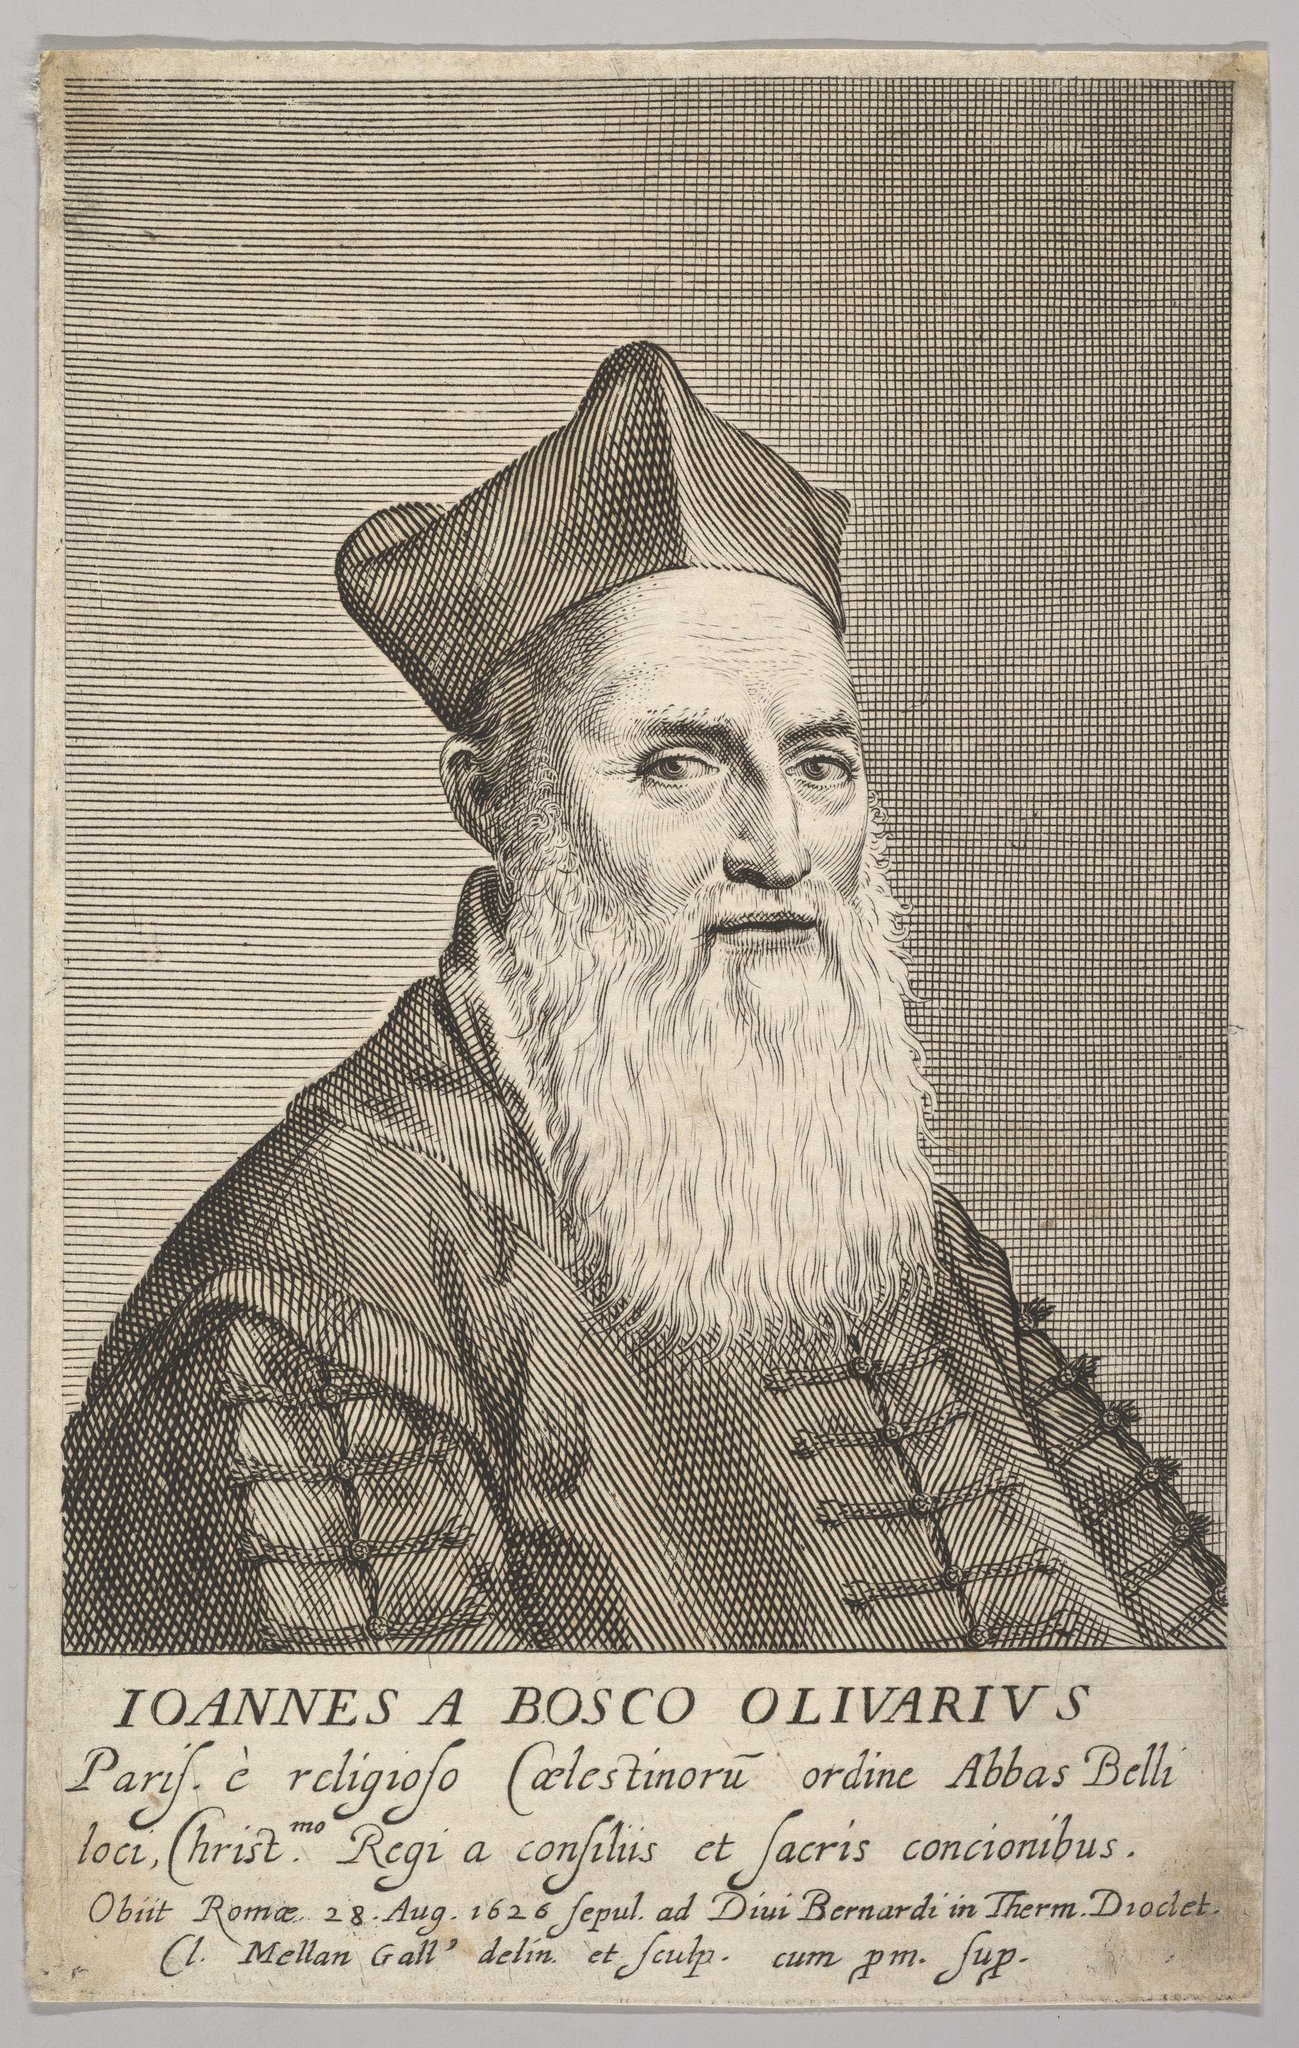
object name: print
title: Le Père Jean Du Bois-Olivier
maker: claude mellan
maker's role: artist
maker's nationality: french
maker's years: 1598-1688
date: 1620-1688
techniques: engraving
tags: men,portraits